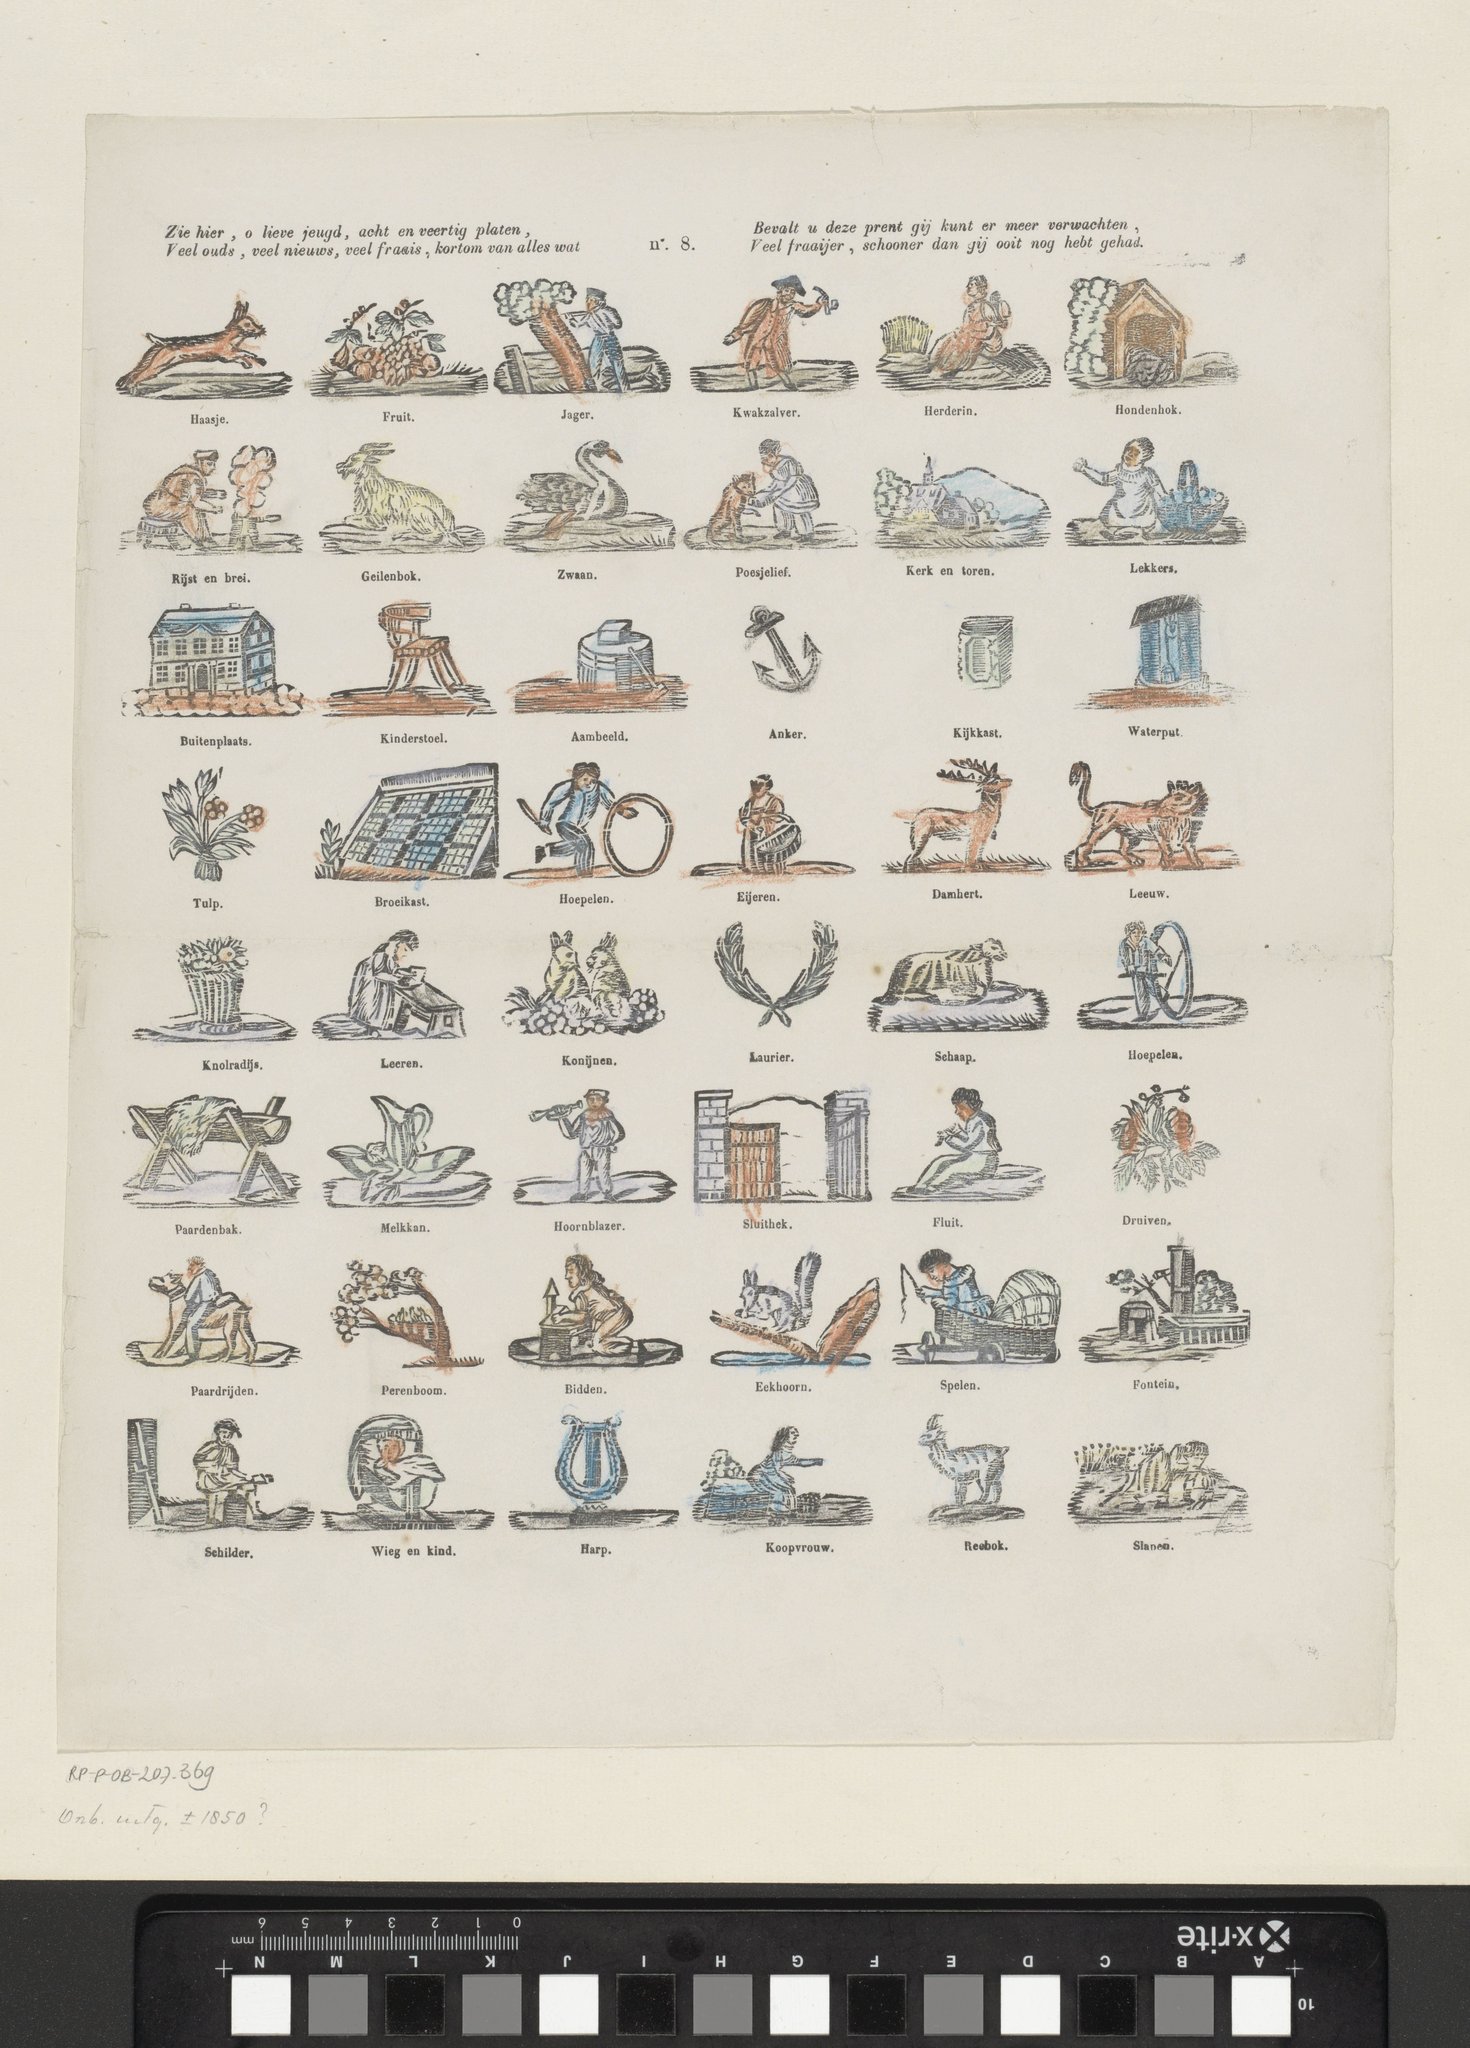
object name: print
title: Zie hier, o lieve jeugd, acht en veertig platen, / Veel ouds, veel nieuws, veel fraais, kortom van alles wat. / Bevalt u deze prent gij kunt er meer verwachten, / Veel fraaijer, schooner dan gij ooit nog hebt gehad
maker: Anonymous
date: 1848-1881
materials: chalk, paper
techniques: colour, letterpress printing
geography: netherlands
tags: animals, human types, characters (human types)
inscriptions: collector's mark: Lugt 2760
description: Blad met 48 voorstellingen van verschillende voorwerpen, dieren en figuren. Onder elke afbeelding een onderschrift. Genummerd midden boven: no. 8.